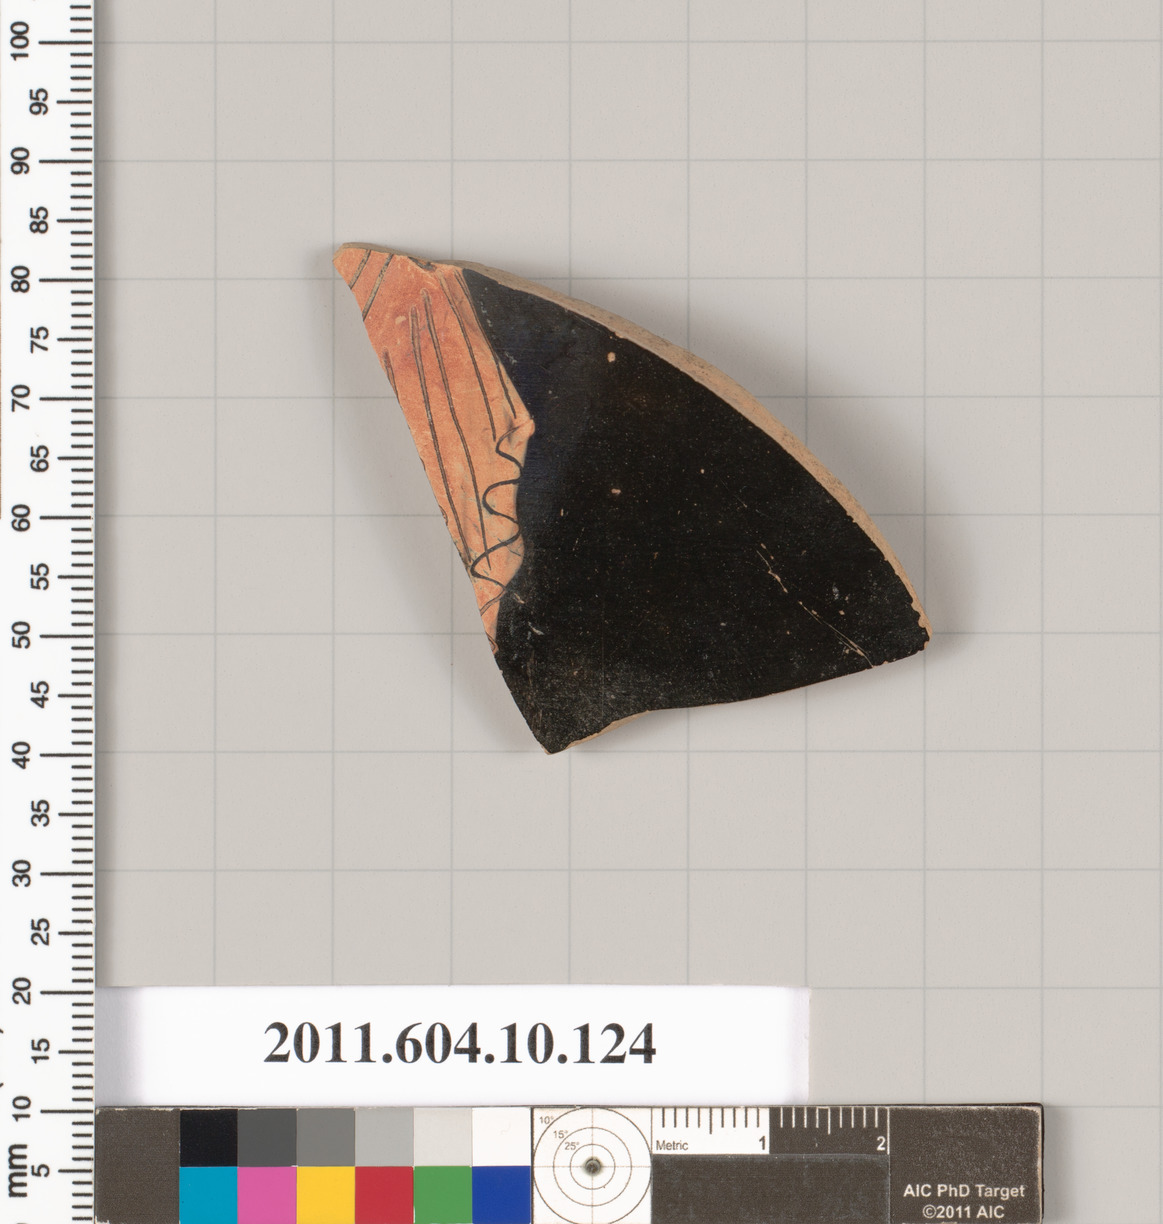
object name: undetermined closed shape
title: Terracotta fragment of a closed shape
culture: etruscan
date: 434-401 BCE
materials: terracotta